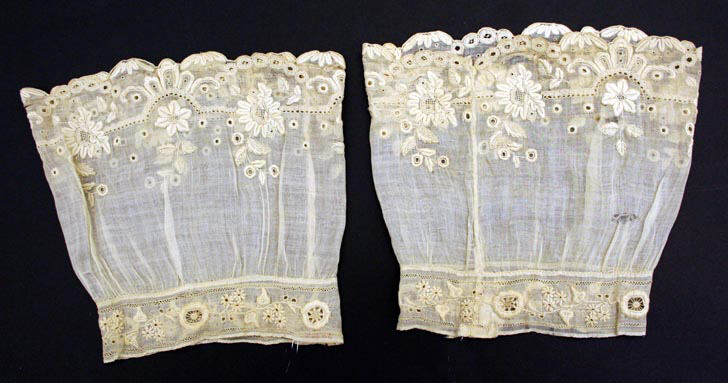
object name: cuff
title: Cuffs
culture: american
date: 1834-1866